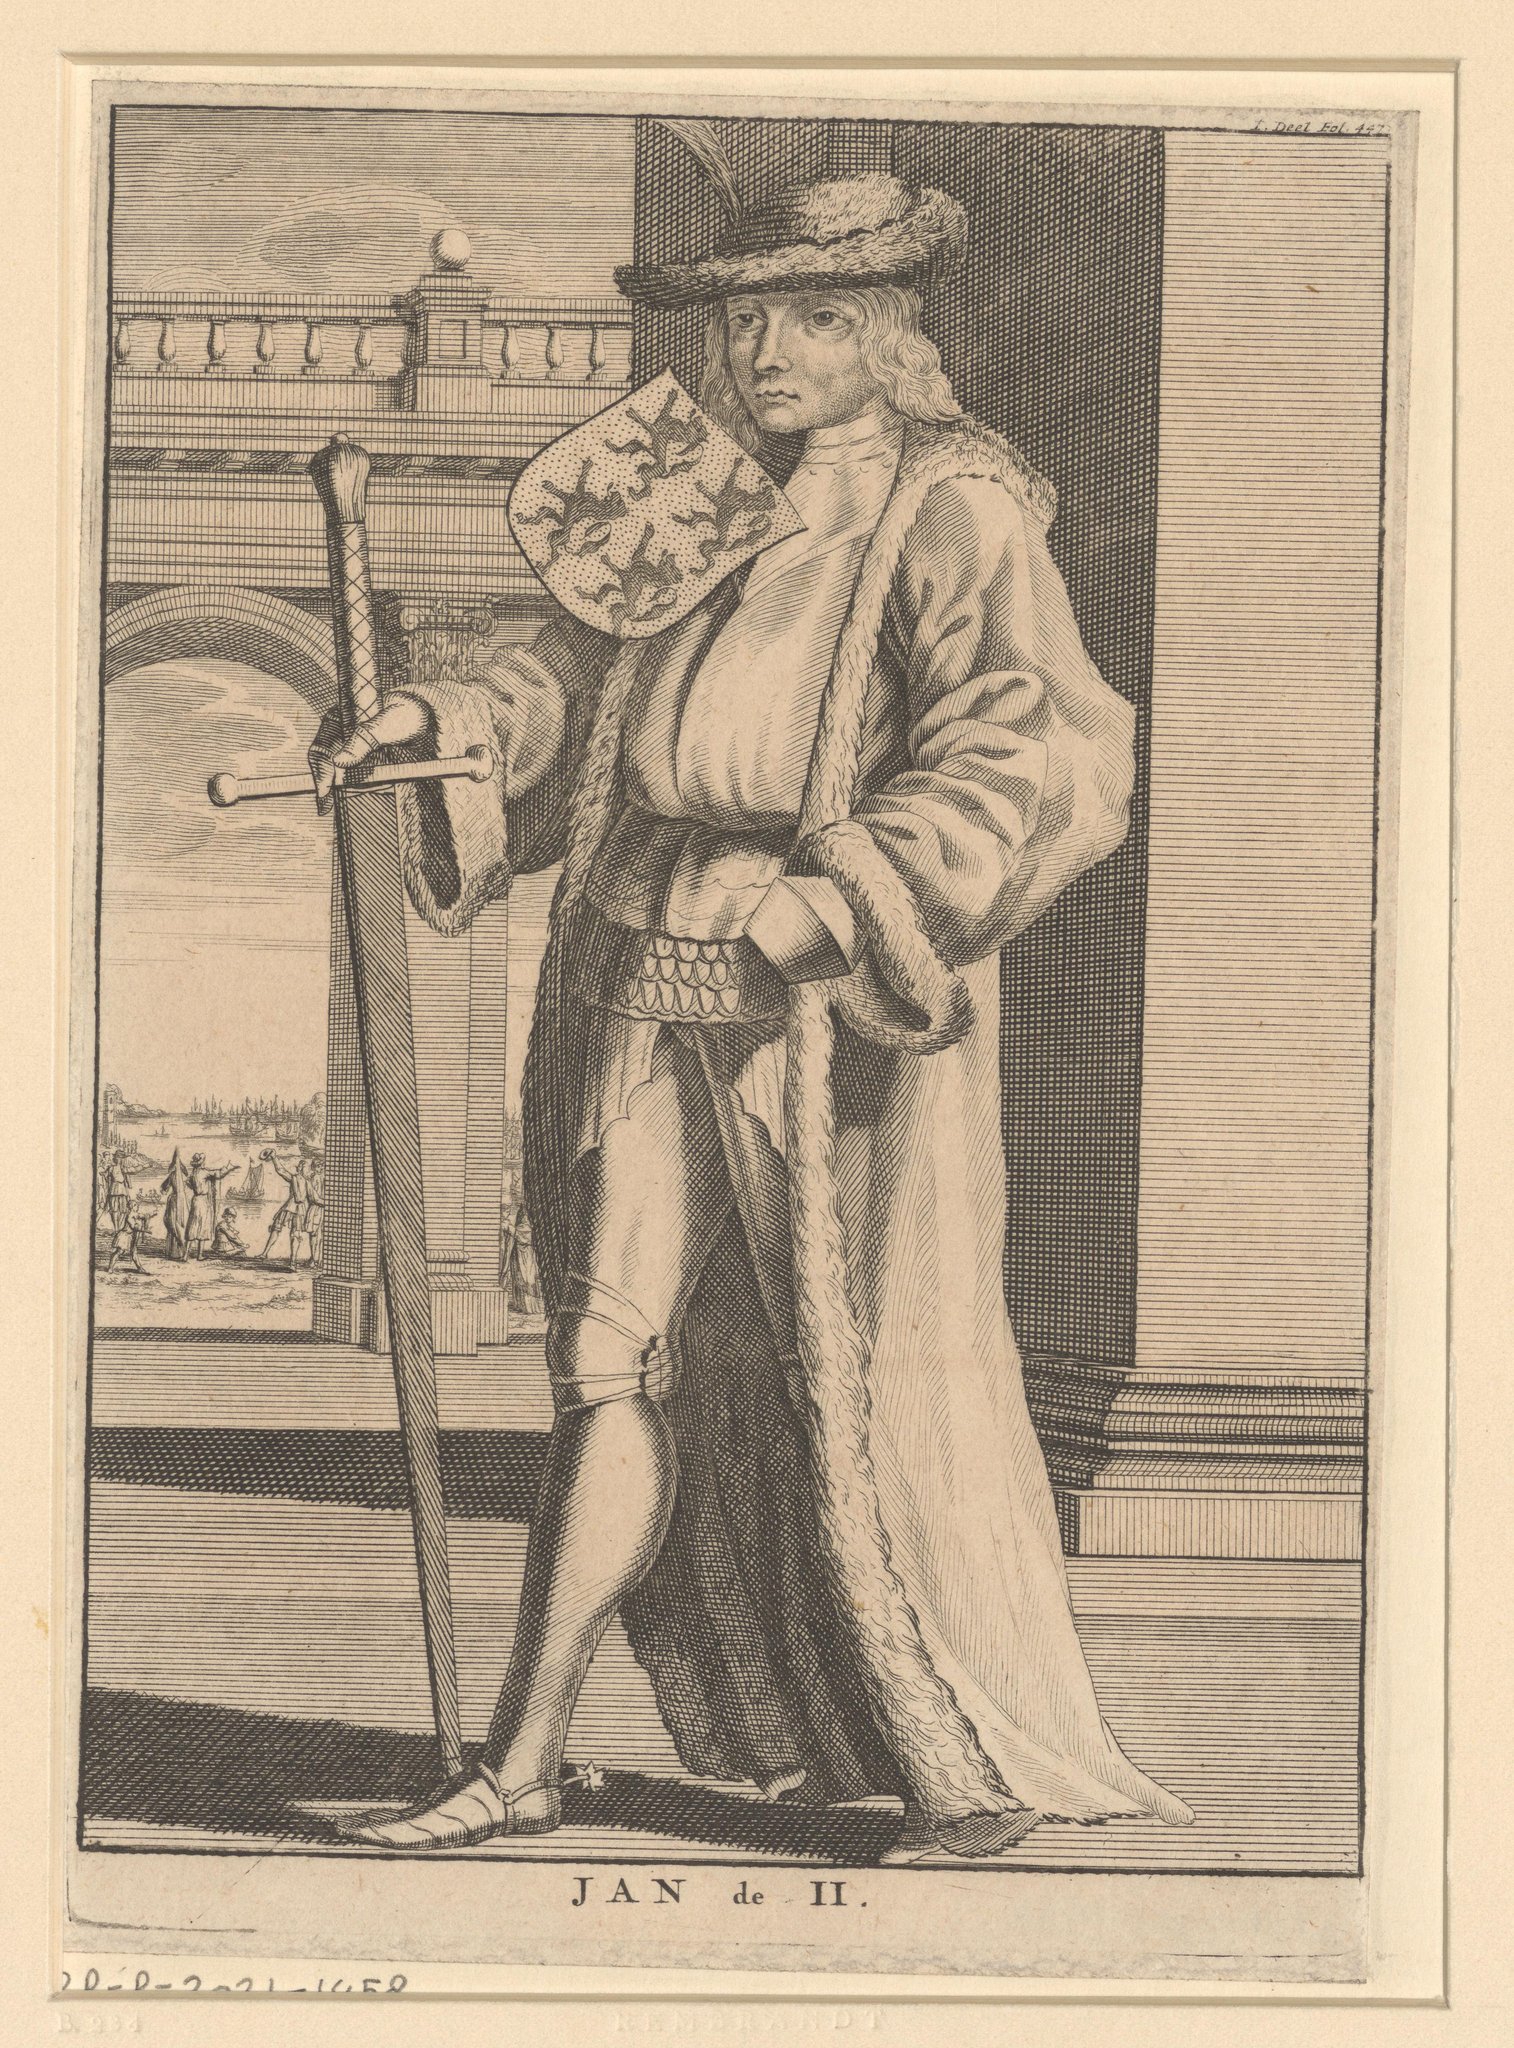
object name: print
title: Portret van Jan II, graaf van Holland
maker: Anonymous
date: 1725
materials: paper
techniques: engraving, etching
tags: historical persons, weapons, ruler, sovereign, armorial bearing, heraldry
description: Prent met omlijsting gebruikt in: Halma, François. Tooneel der Vereenigde Nederlanden, en onderhorige landschappen (...). 2 dln. Leeuwarden: Hendrik Halma, 1725, dl. 1, tussen p. 446-447. Eerdere staat van prent gebruikt in: Stoke, Melis. Hollandse jaar-boeken of rijm-kronijk van Melis Stoke. Behelsende de geschiedenissen des lands (...). Leiden: Johannes du Vivié en Isaak Severinus, 1699.